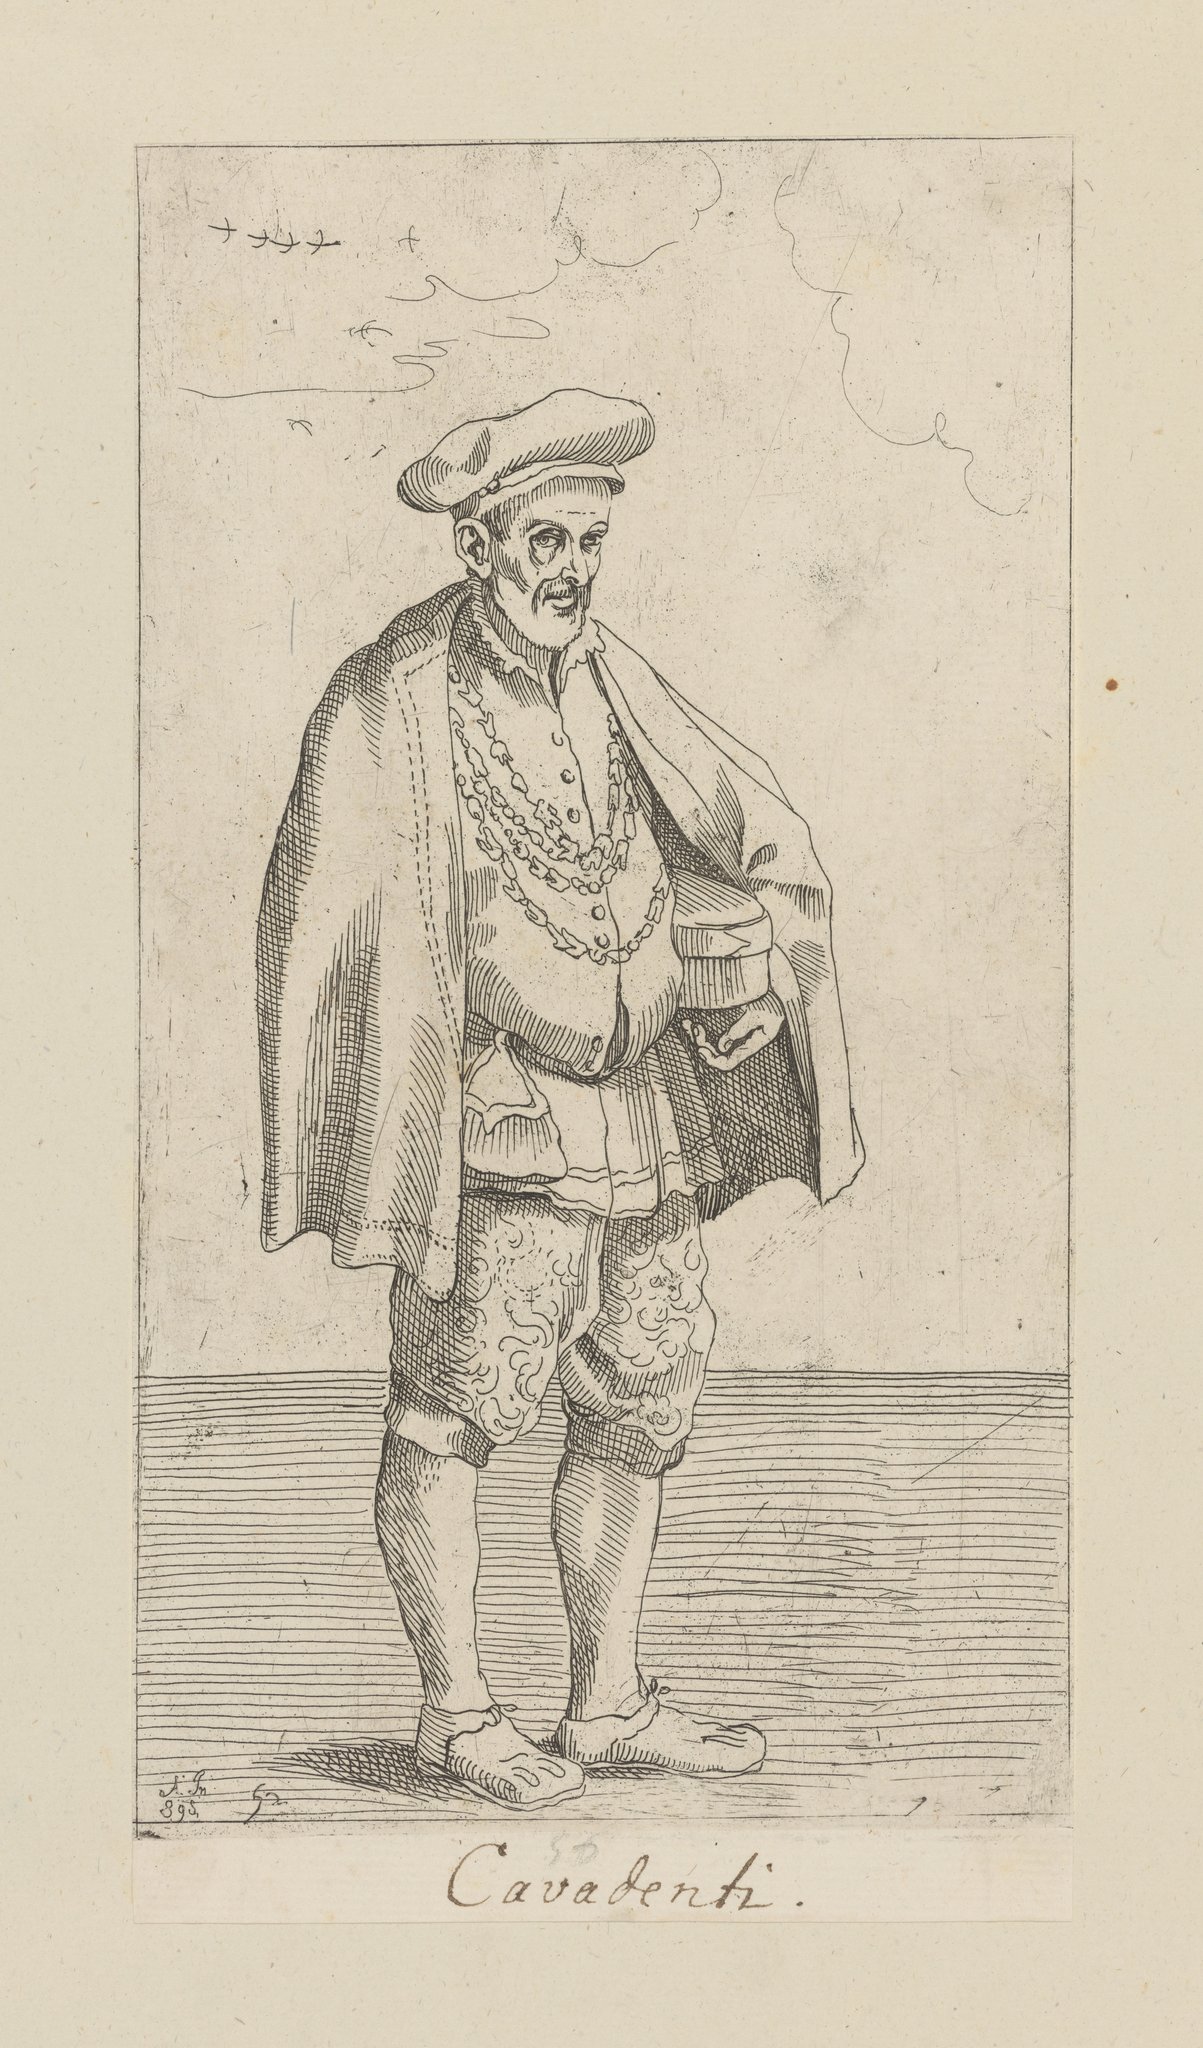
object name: print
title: Plate 52: Tooth puller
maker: simon guillain ii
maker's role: artist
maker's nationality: french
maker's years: 1618-1718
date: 1646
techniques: etching